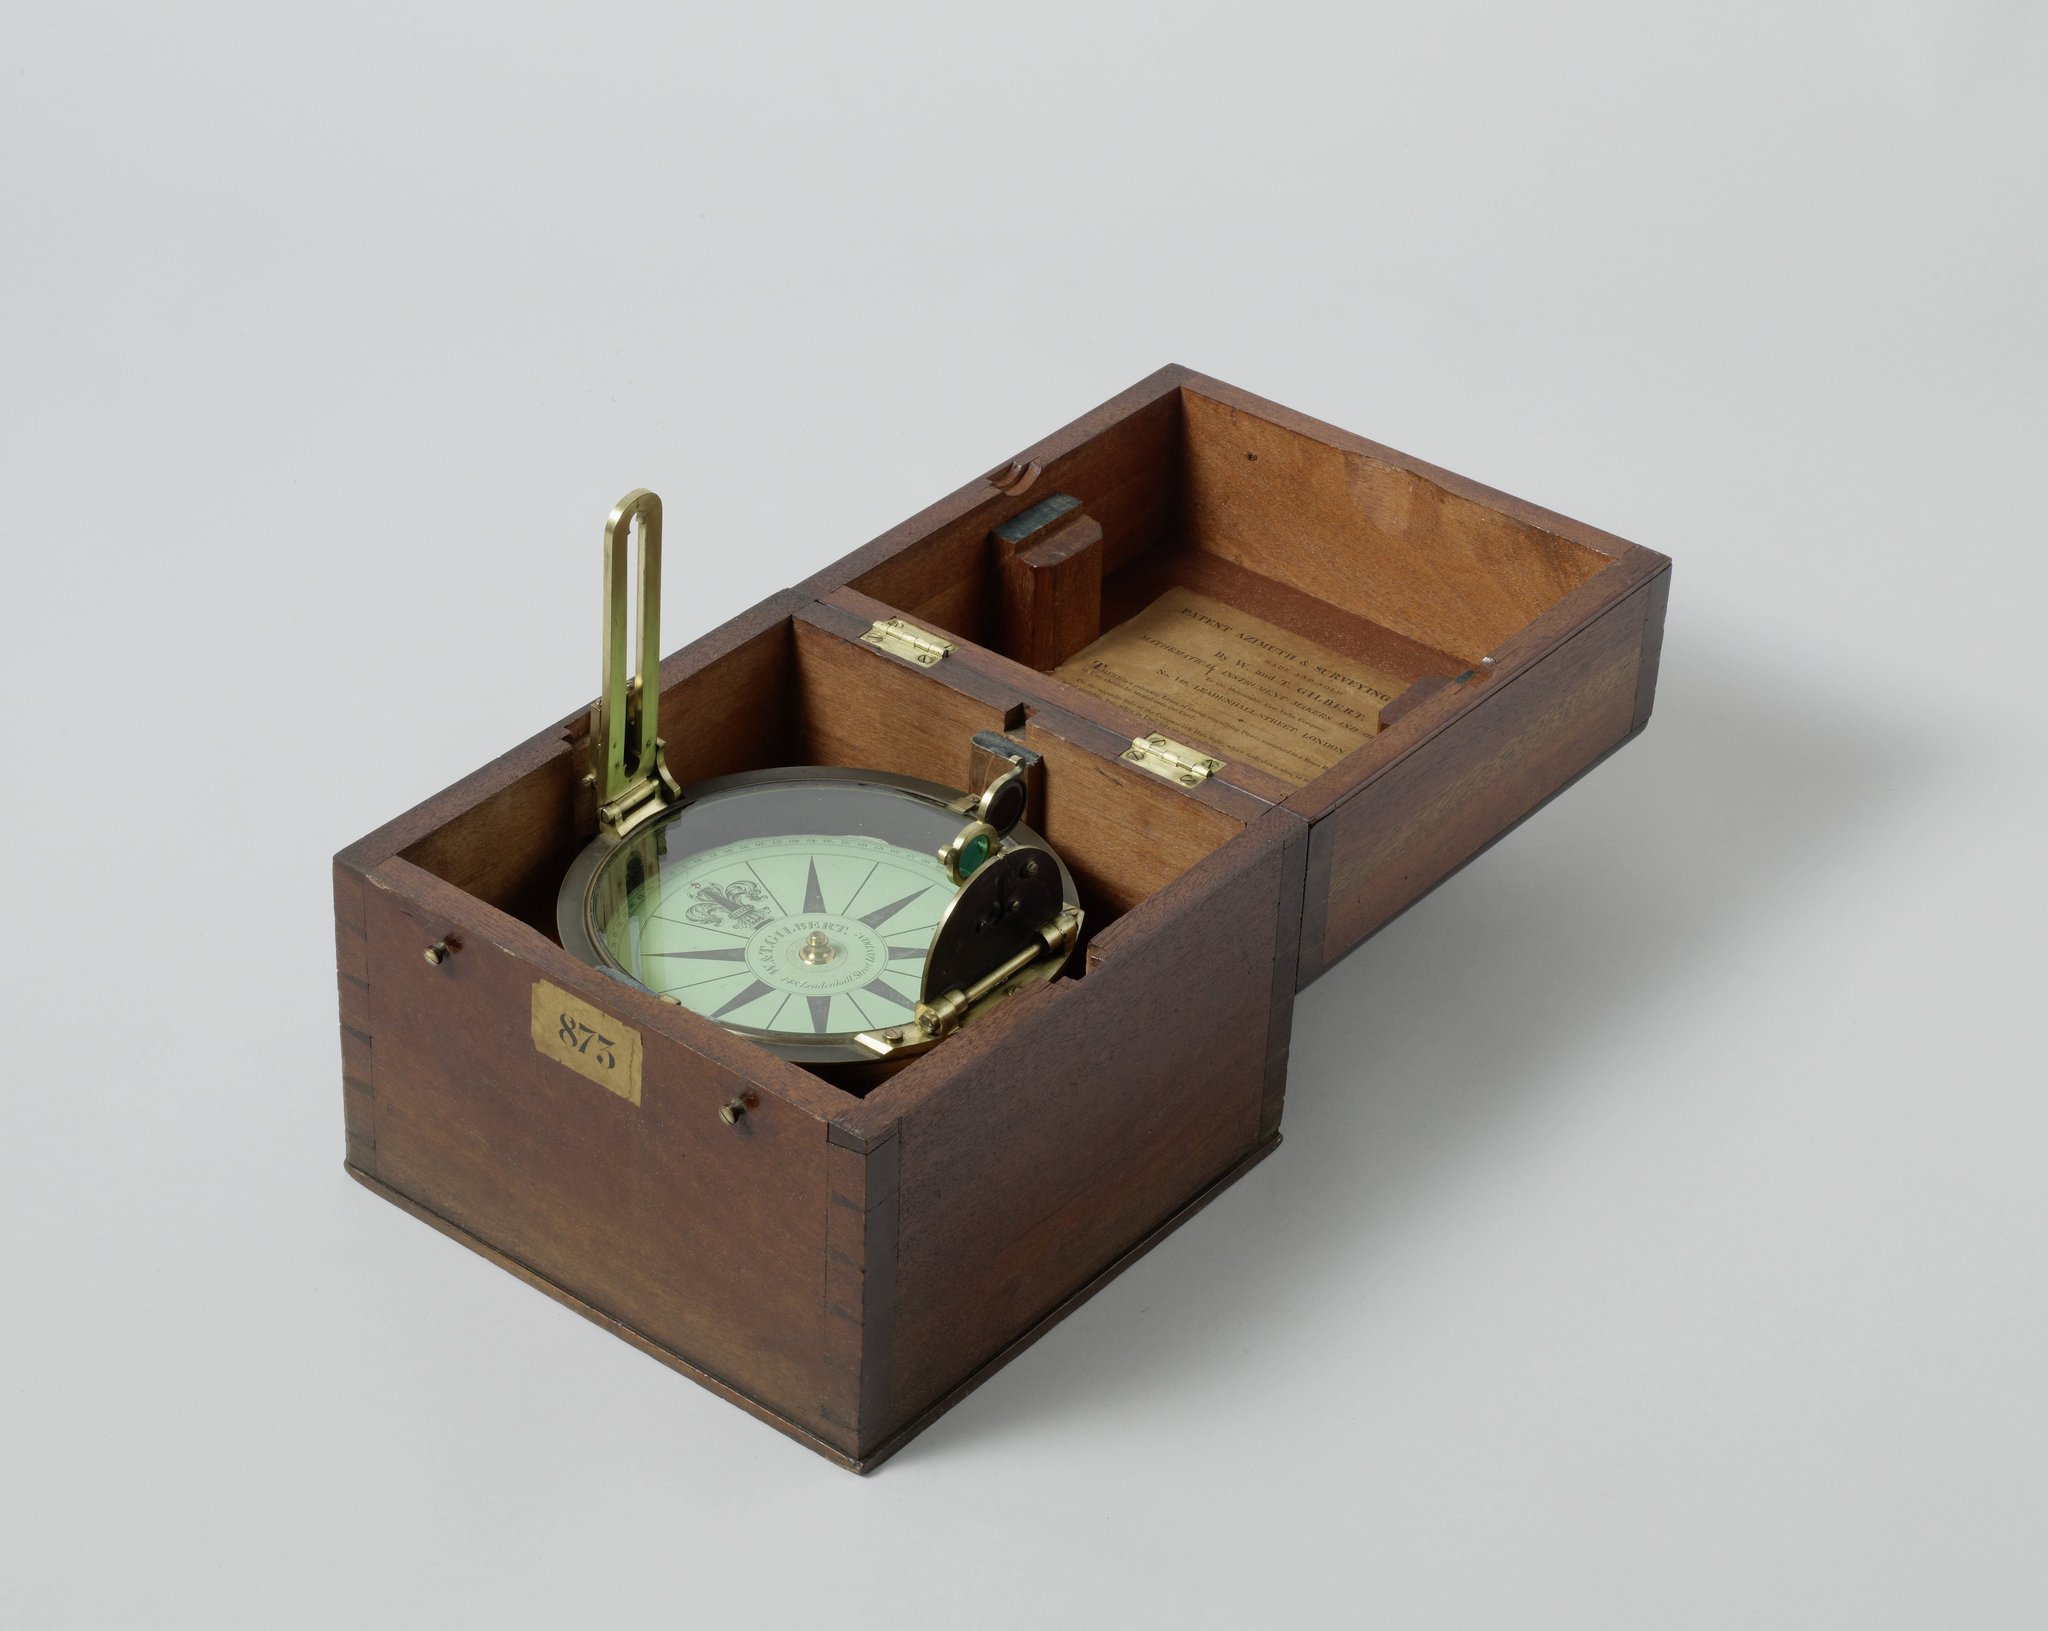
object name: box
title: Azimuth Compass in Wooden Box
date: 1810-1858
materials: brass, glass, iron, lead, paper, gemstone, wood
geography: london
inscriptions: label, on the compass box: ‘873’ former inventory label, inscription, on the compass card: ‘W. & T. GILBERT, / 148, Leadenhall Street LONDON.’, inscription, on the compass box: ‘PATENT AZIMUTH & SURVEYING COMPASS, / MADE AND SOLD / By W. and T. GILBERT, / MATHEMATICAL INSTRUMENT-MAKERS AND OPTICIANS, / To the Honourable the East India Company, / nr. 148, LEADENHALL-STREET, LONDON.’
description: Dit kompas was bekend onder de naam Patent Azimuth and Surveying Compass.